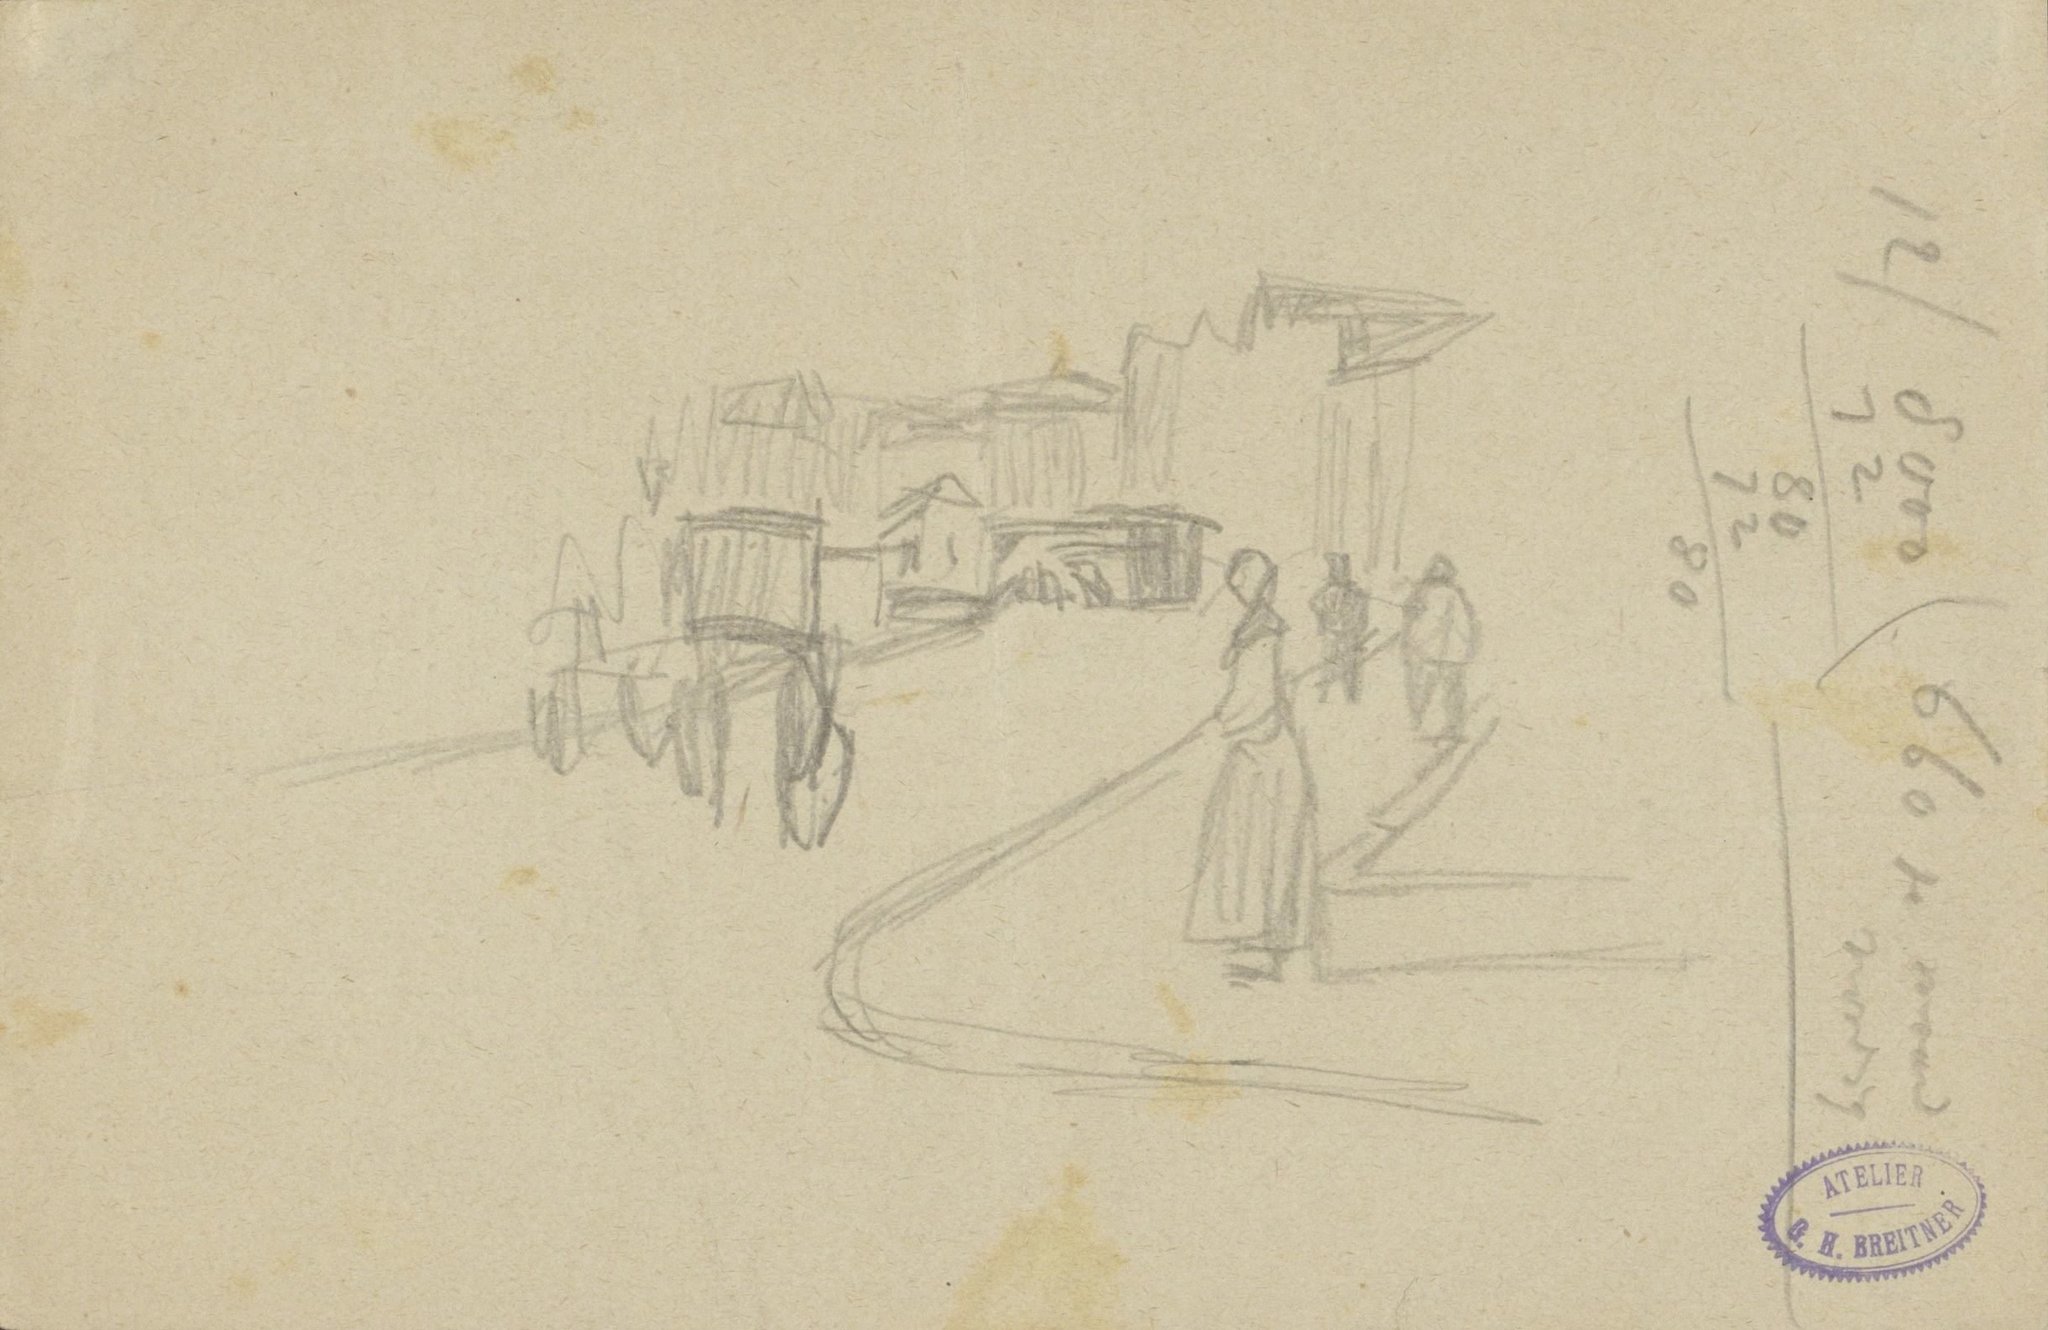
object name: drawing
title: Gezicht op het Rokin te Amsterdam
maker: george hendrik breitner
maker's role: draughtsman, painter, print maker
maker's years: 1857-1923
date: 1897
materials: paper, pencil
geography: amsterdam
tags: street (+ city(-scape) with figures, staffage)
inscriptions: annotation: ‘[...]’, collector's mark: Lugt 2228, workshop stamp: Lugt 291d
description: Met rijtuigen en figuren. In de bocht waarschijnlijk kunstenaarsvereniging Arti et Amicitiae. Verso een tabel met belastingtarieven.